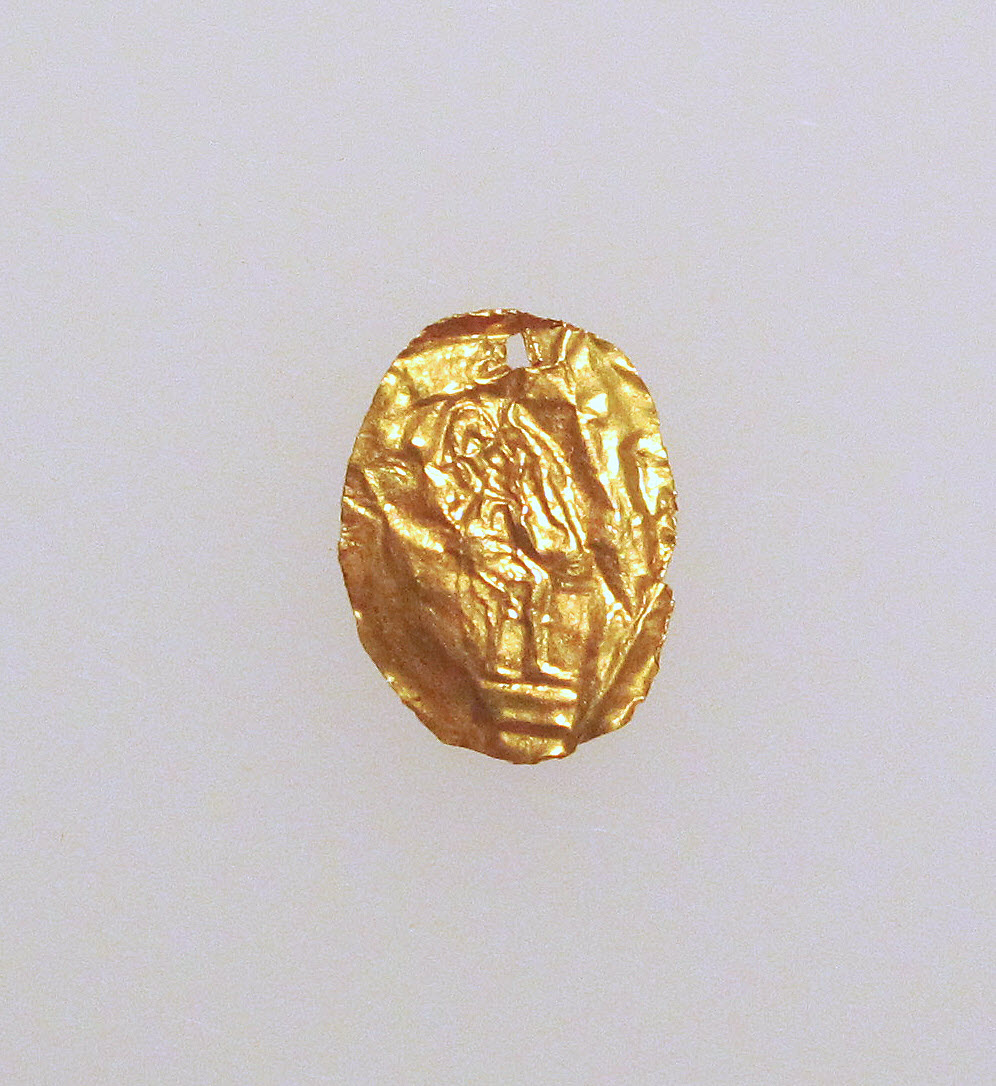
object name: roundel, disk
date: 400-301 BCE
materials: gold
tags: human figures